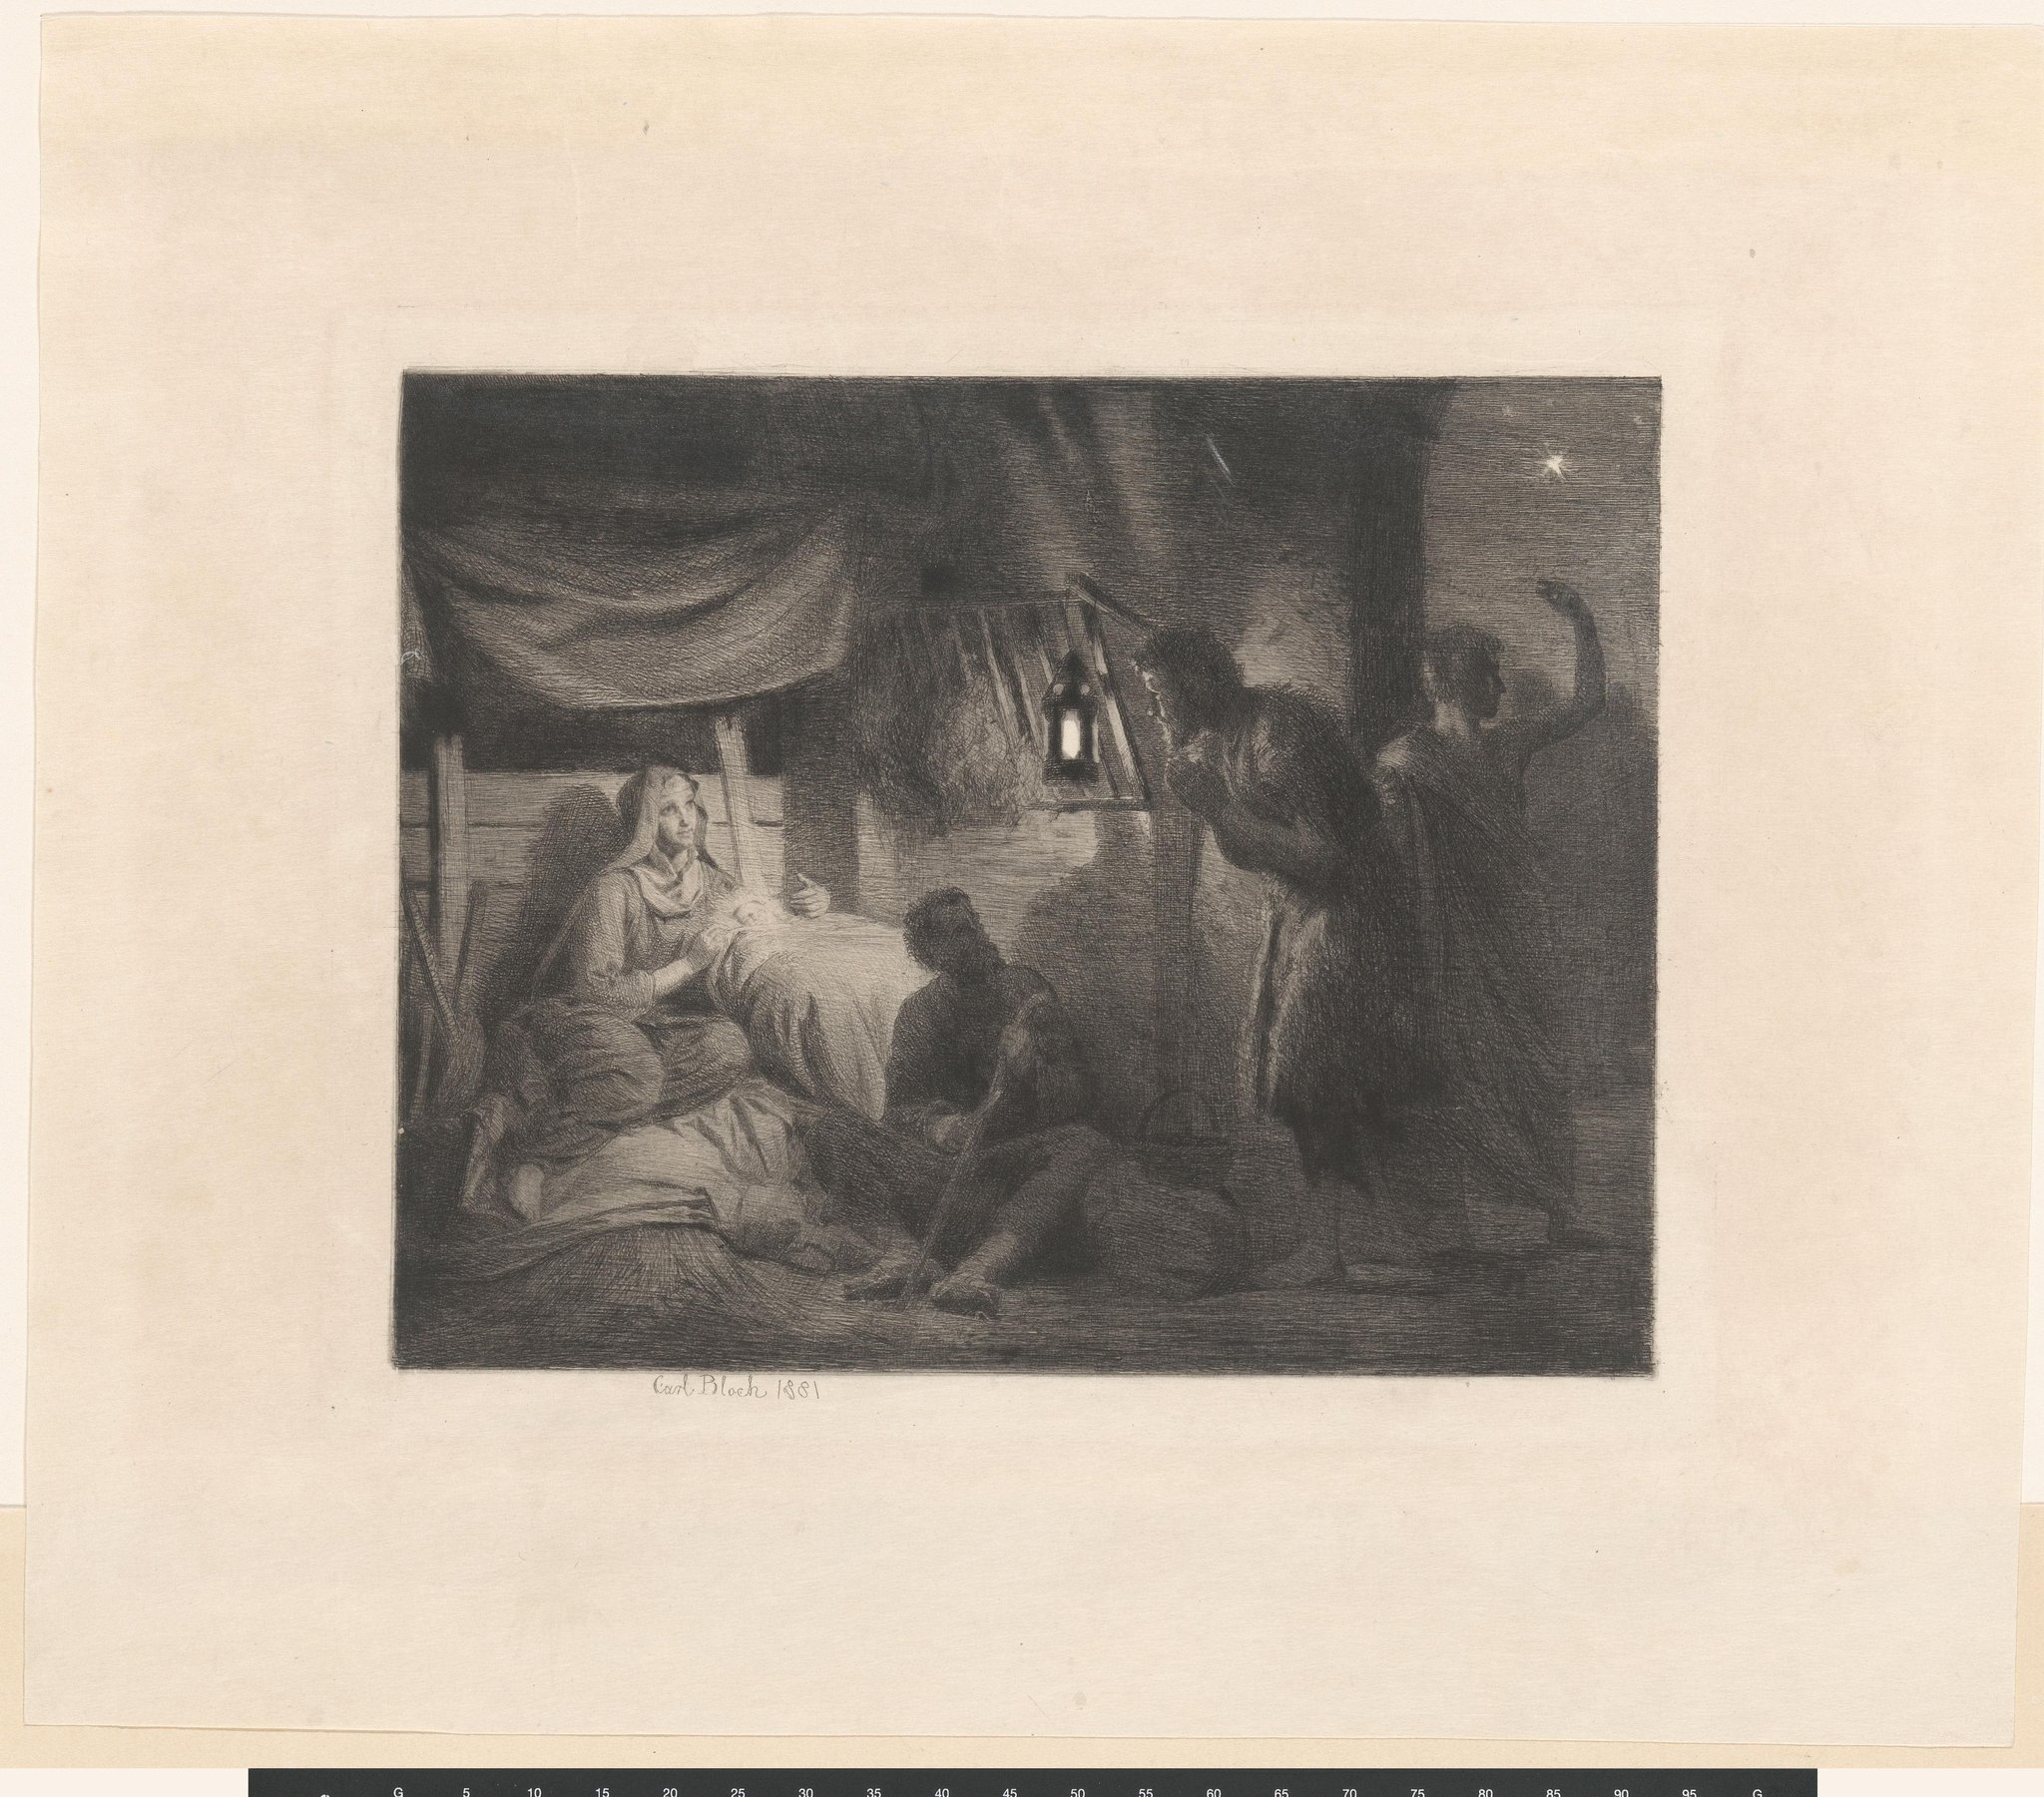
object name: print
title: De aanbidding der herders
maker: carl bloch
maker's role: print maker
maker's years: 1834-1890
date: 1881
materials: paper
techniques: drypoint, etching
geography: scandinavia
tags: adoration of the christ-child by the shepherds; mary and joseph present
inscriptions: collector's mark: Lugt 2228, signature and date: ‘m.o. in de marge: Carl Bloch 1881’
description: Maria en Jozef met kind zittend in een stal, bijgelicht door de lantaarn van binnenkomende herders.